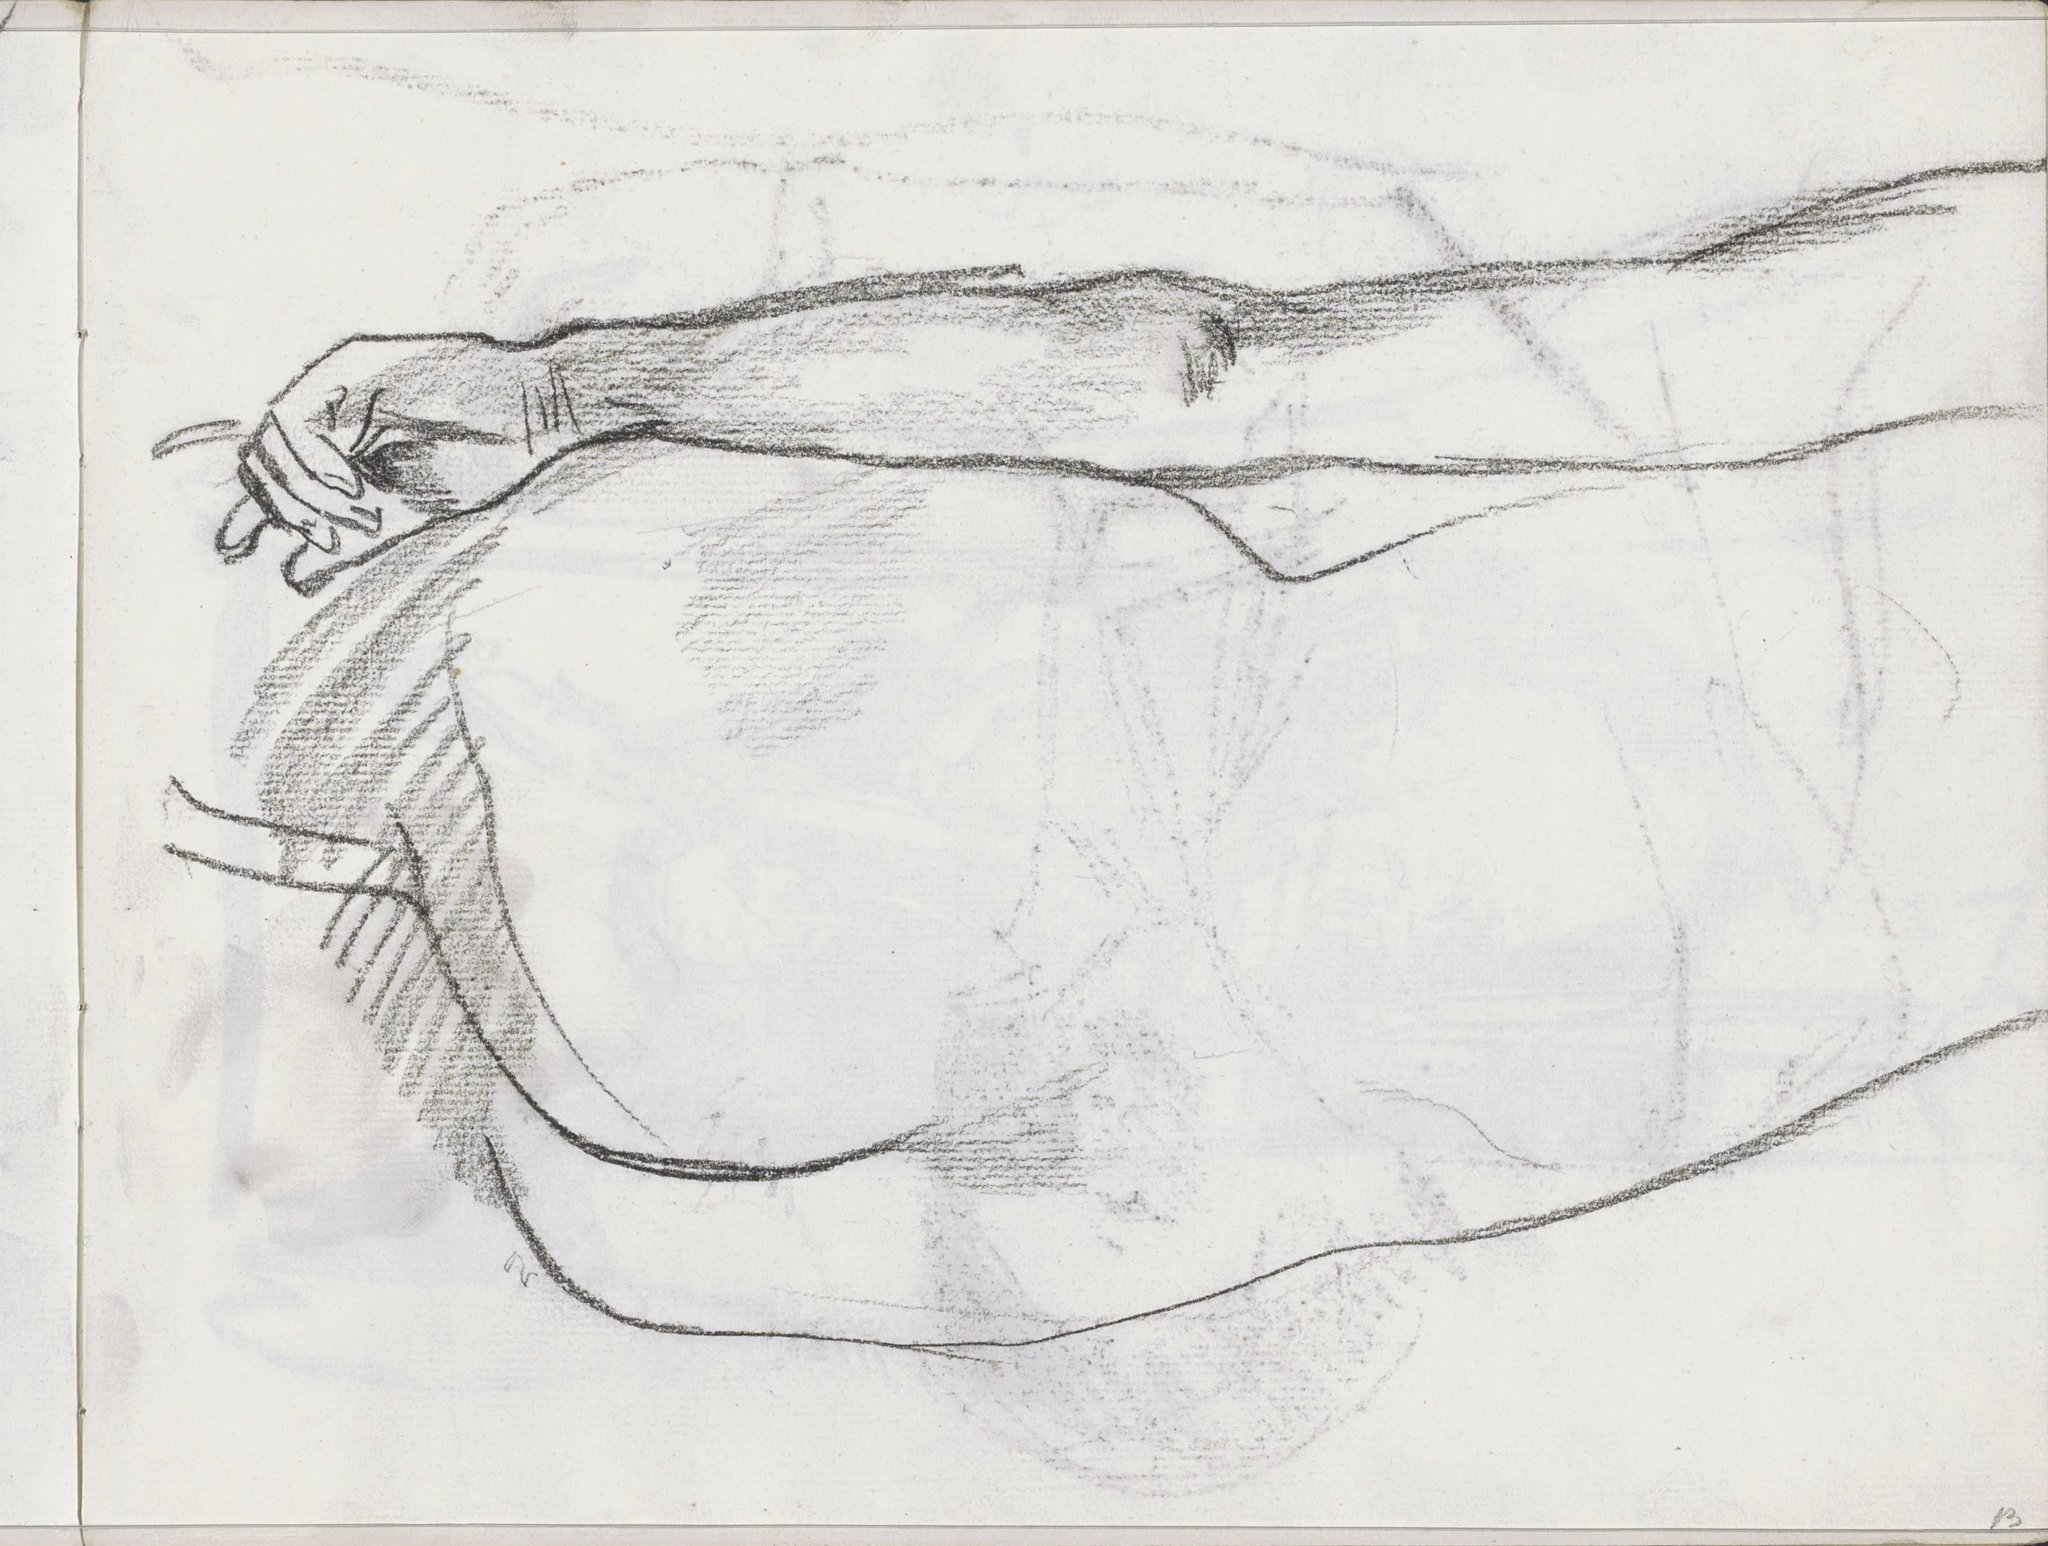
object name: sketchbook leaf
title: Liggend vrouwelijk naakt, op de rug gezien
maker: isaac israels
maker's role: draughtsman, painter, print maker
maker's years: 1865-1934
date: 1875-1934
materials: chalk, paper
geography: the hague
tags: lying figure - aa - female human figure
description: Blad 13 recto uit schetsboek XIV met 17 bladen.